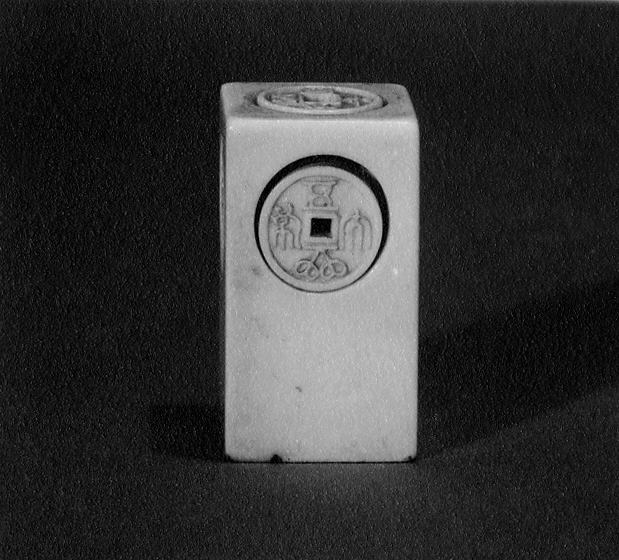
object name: seal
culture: chinese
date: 1701-1800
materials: ivory